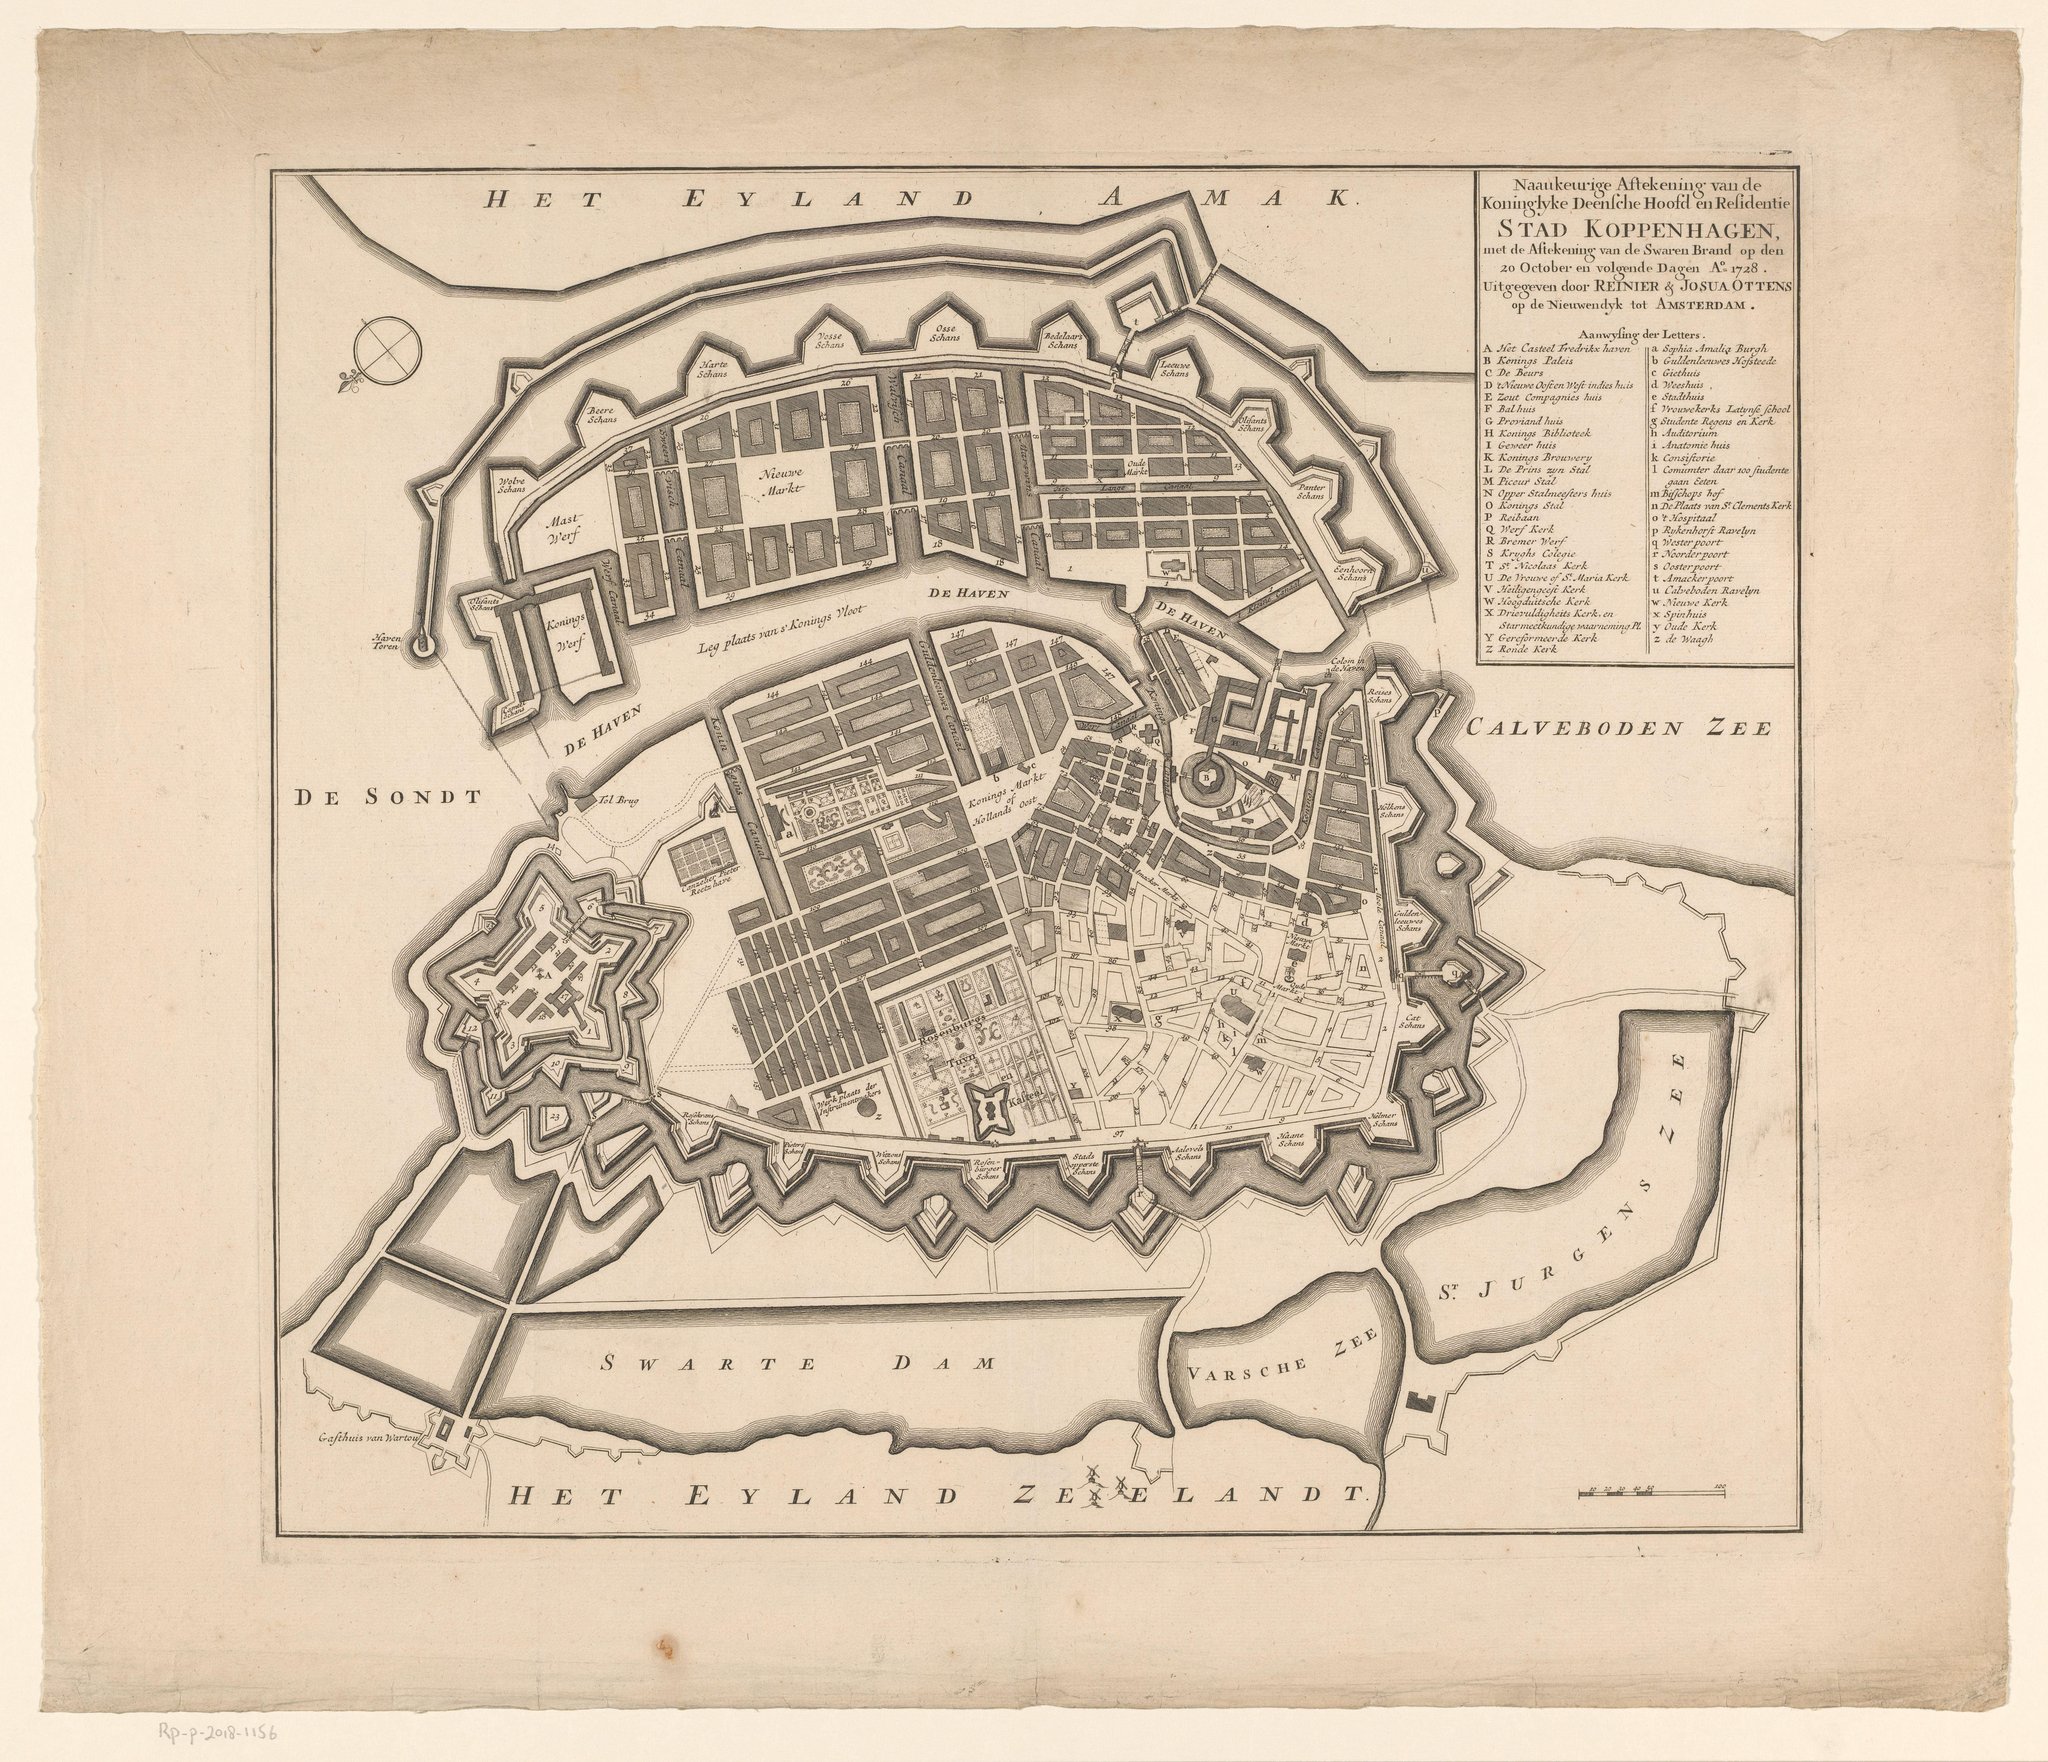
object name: print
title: Plattegrond van Kopenhagen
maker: Anonymous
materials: paper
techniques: engraving, etching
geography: amsterdam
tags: on fire, ablaze, ruin of a building ~ architecture, maps of cities, copenhagen (city)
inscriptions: collector's mark: Lugt 2228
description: Plattegrond van Kopenhagen waar de schade van de brand van oktober 1728 op is aangegeven. Het deel van de stad dat niet is gearceerd (rechtsonder) is tijdens de brand in as gelegd.